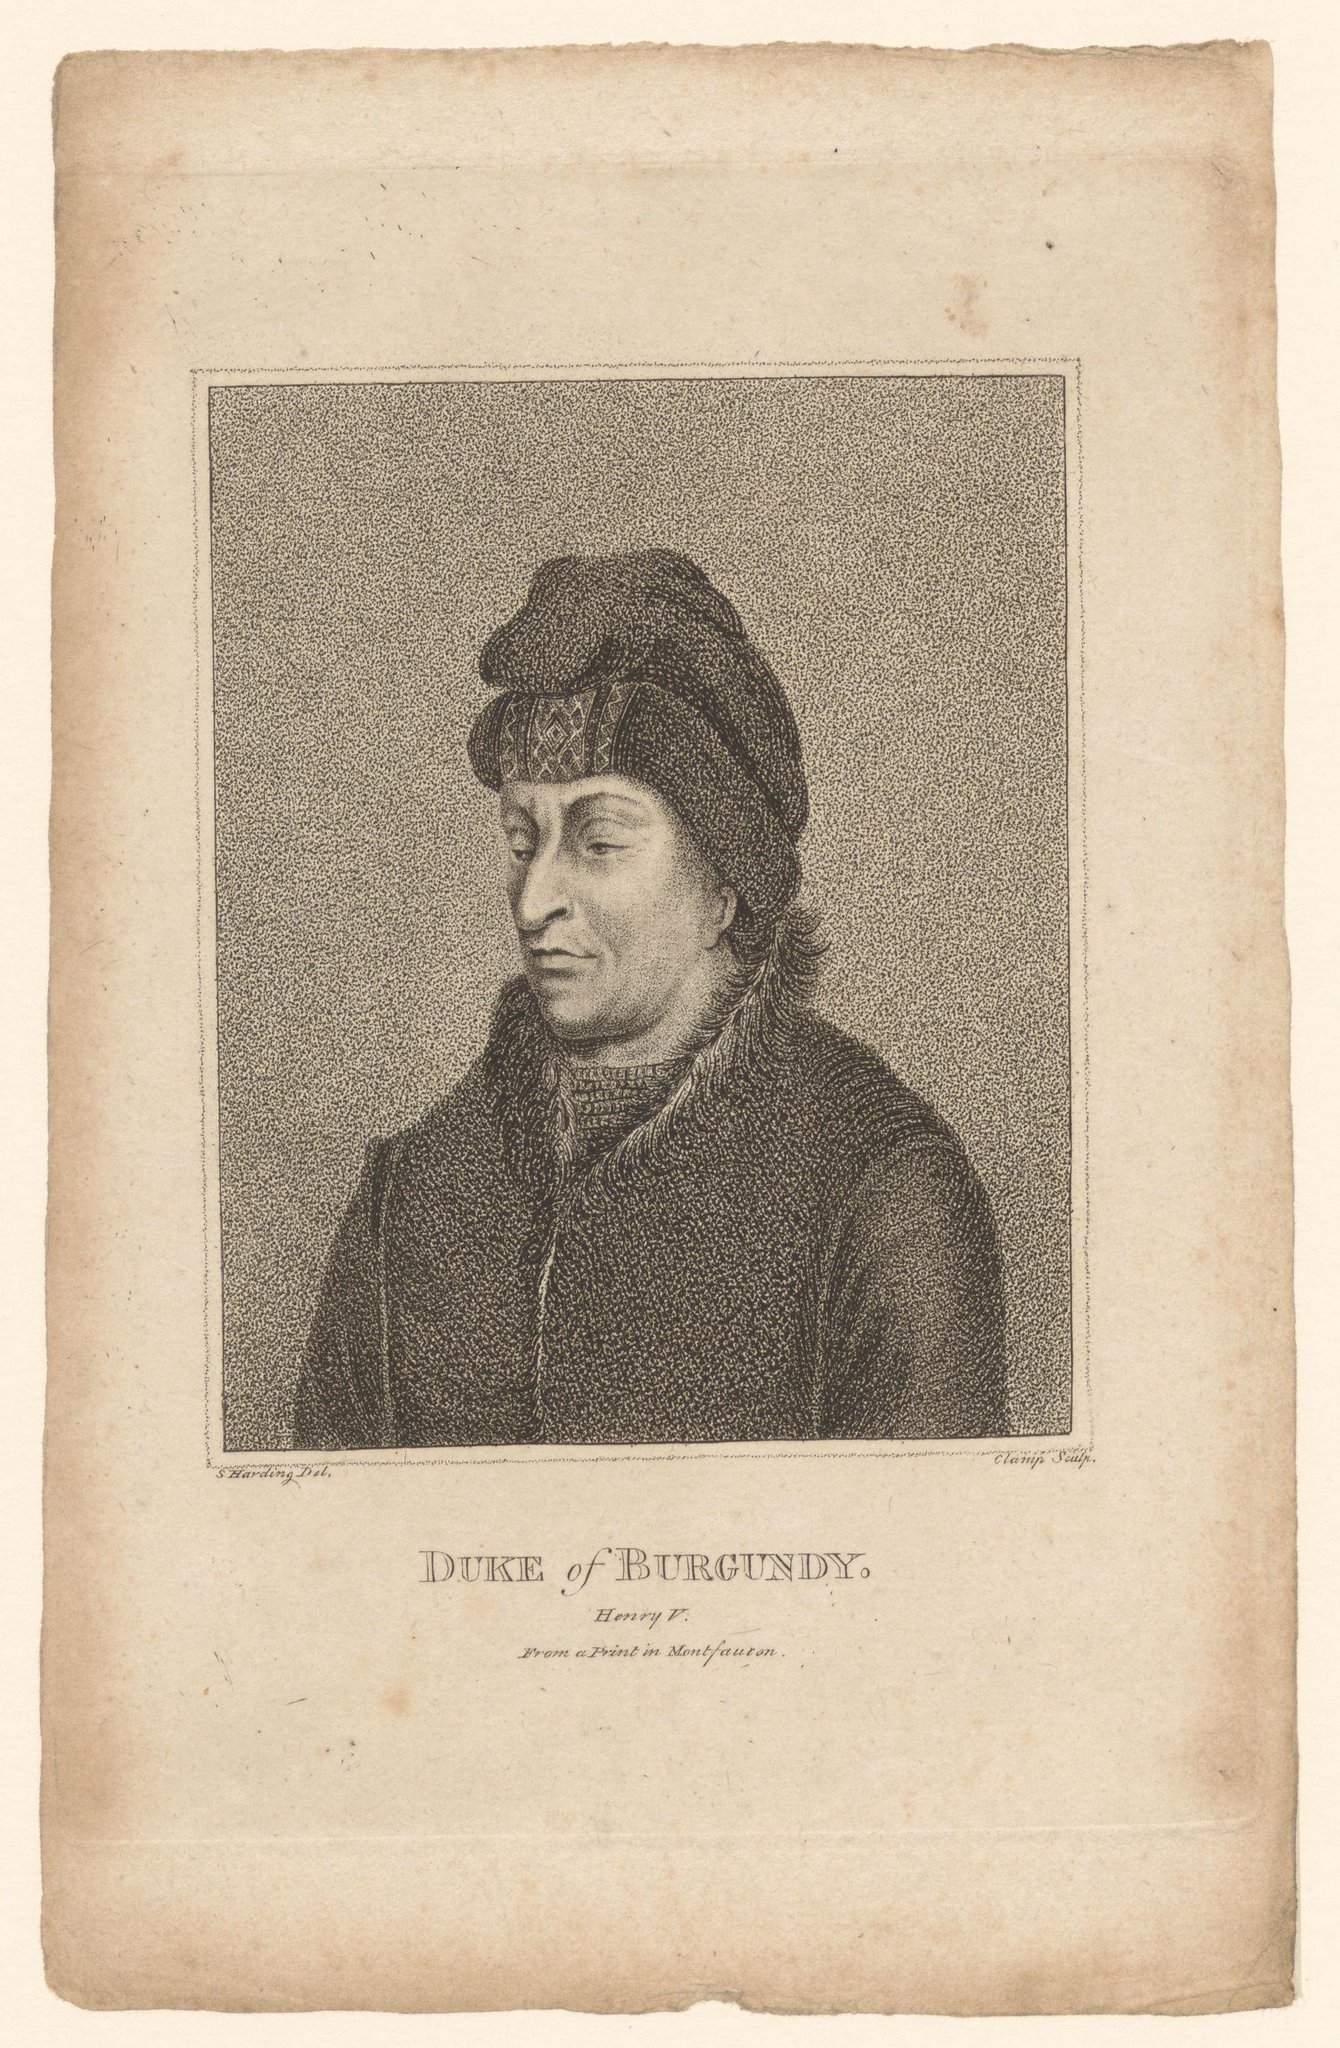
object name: print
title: Portret van Jan zonder Vrees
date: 1793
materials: paper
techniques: etching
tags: historical persons, ruler, sovereign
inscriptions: collector's mark: Lugt 2228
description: Prent gebruikt in: Harding, Sylvester. Shakespeare Illustrated. Londen: Edward Harding, 1793.